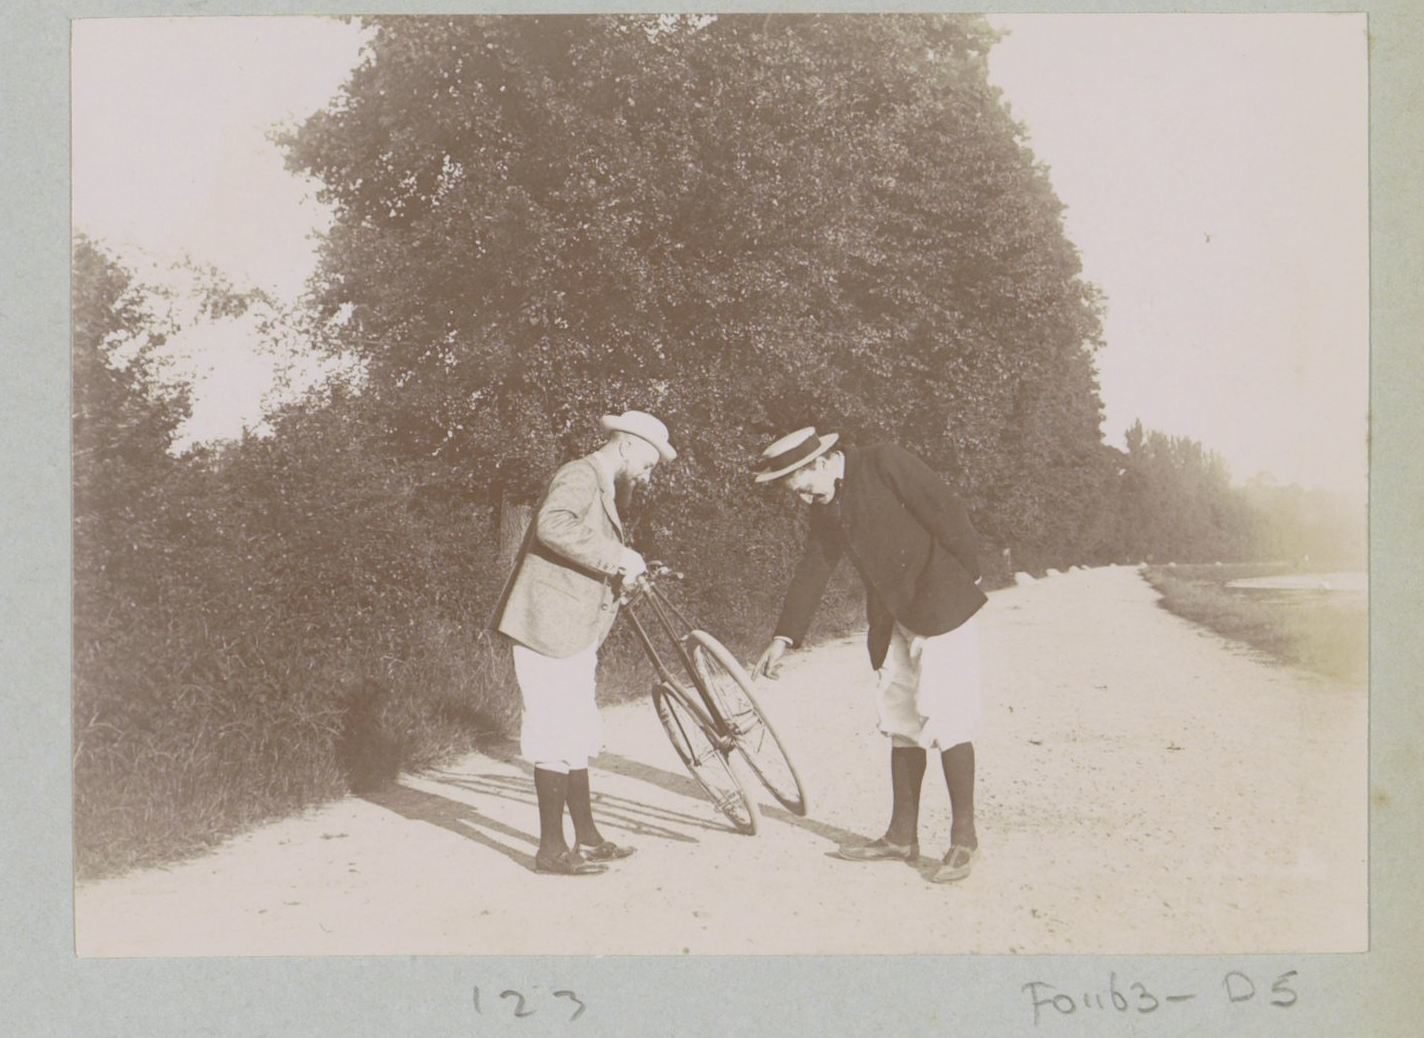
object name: photograph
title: Twee mannen gebogen over een fiets op een weg bij Pontoise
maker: delizy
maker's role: manufacturer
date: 1897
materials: paper, photographic support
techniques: gelatin silver print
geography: pontoise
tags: riding, cycling (recreation), road, path, bicycle, index finger forwards, pointing, indicating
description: Onderdeel van Fotoalbum van een Franse amateurfotograaf met opnames van uitstapjes in Frankrijk, Spanje, België, Luxemburg en Nederland, de eerste automobielen en autoraces.